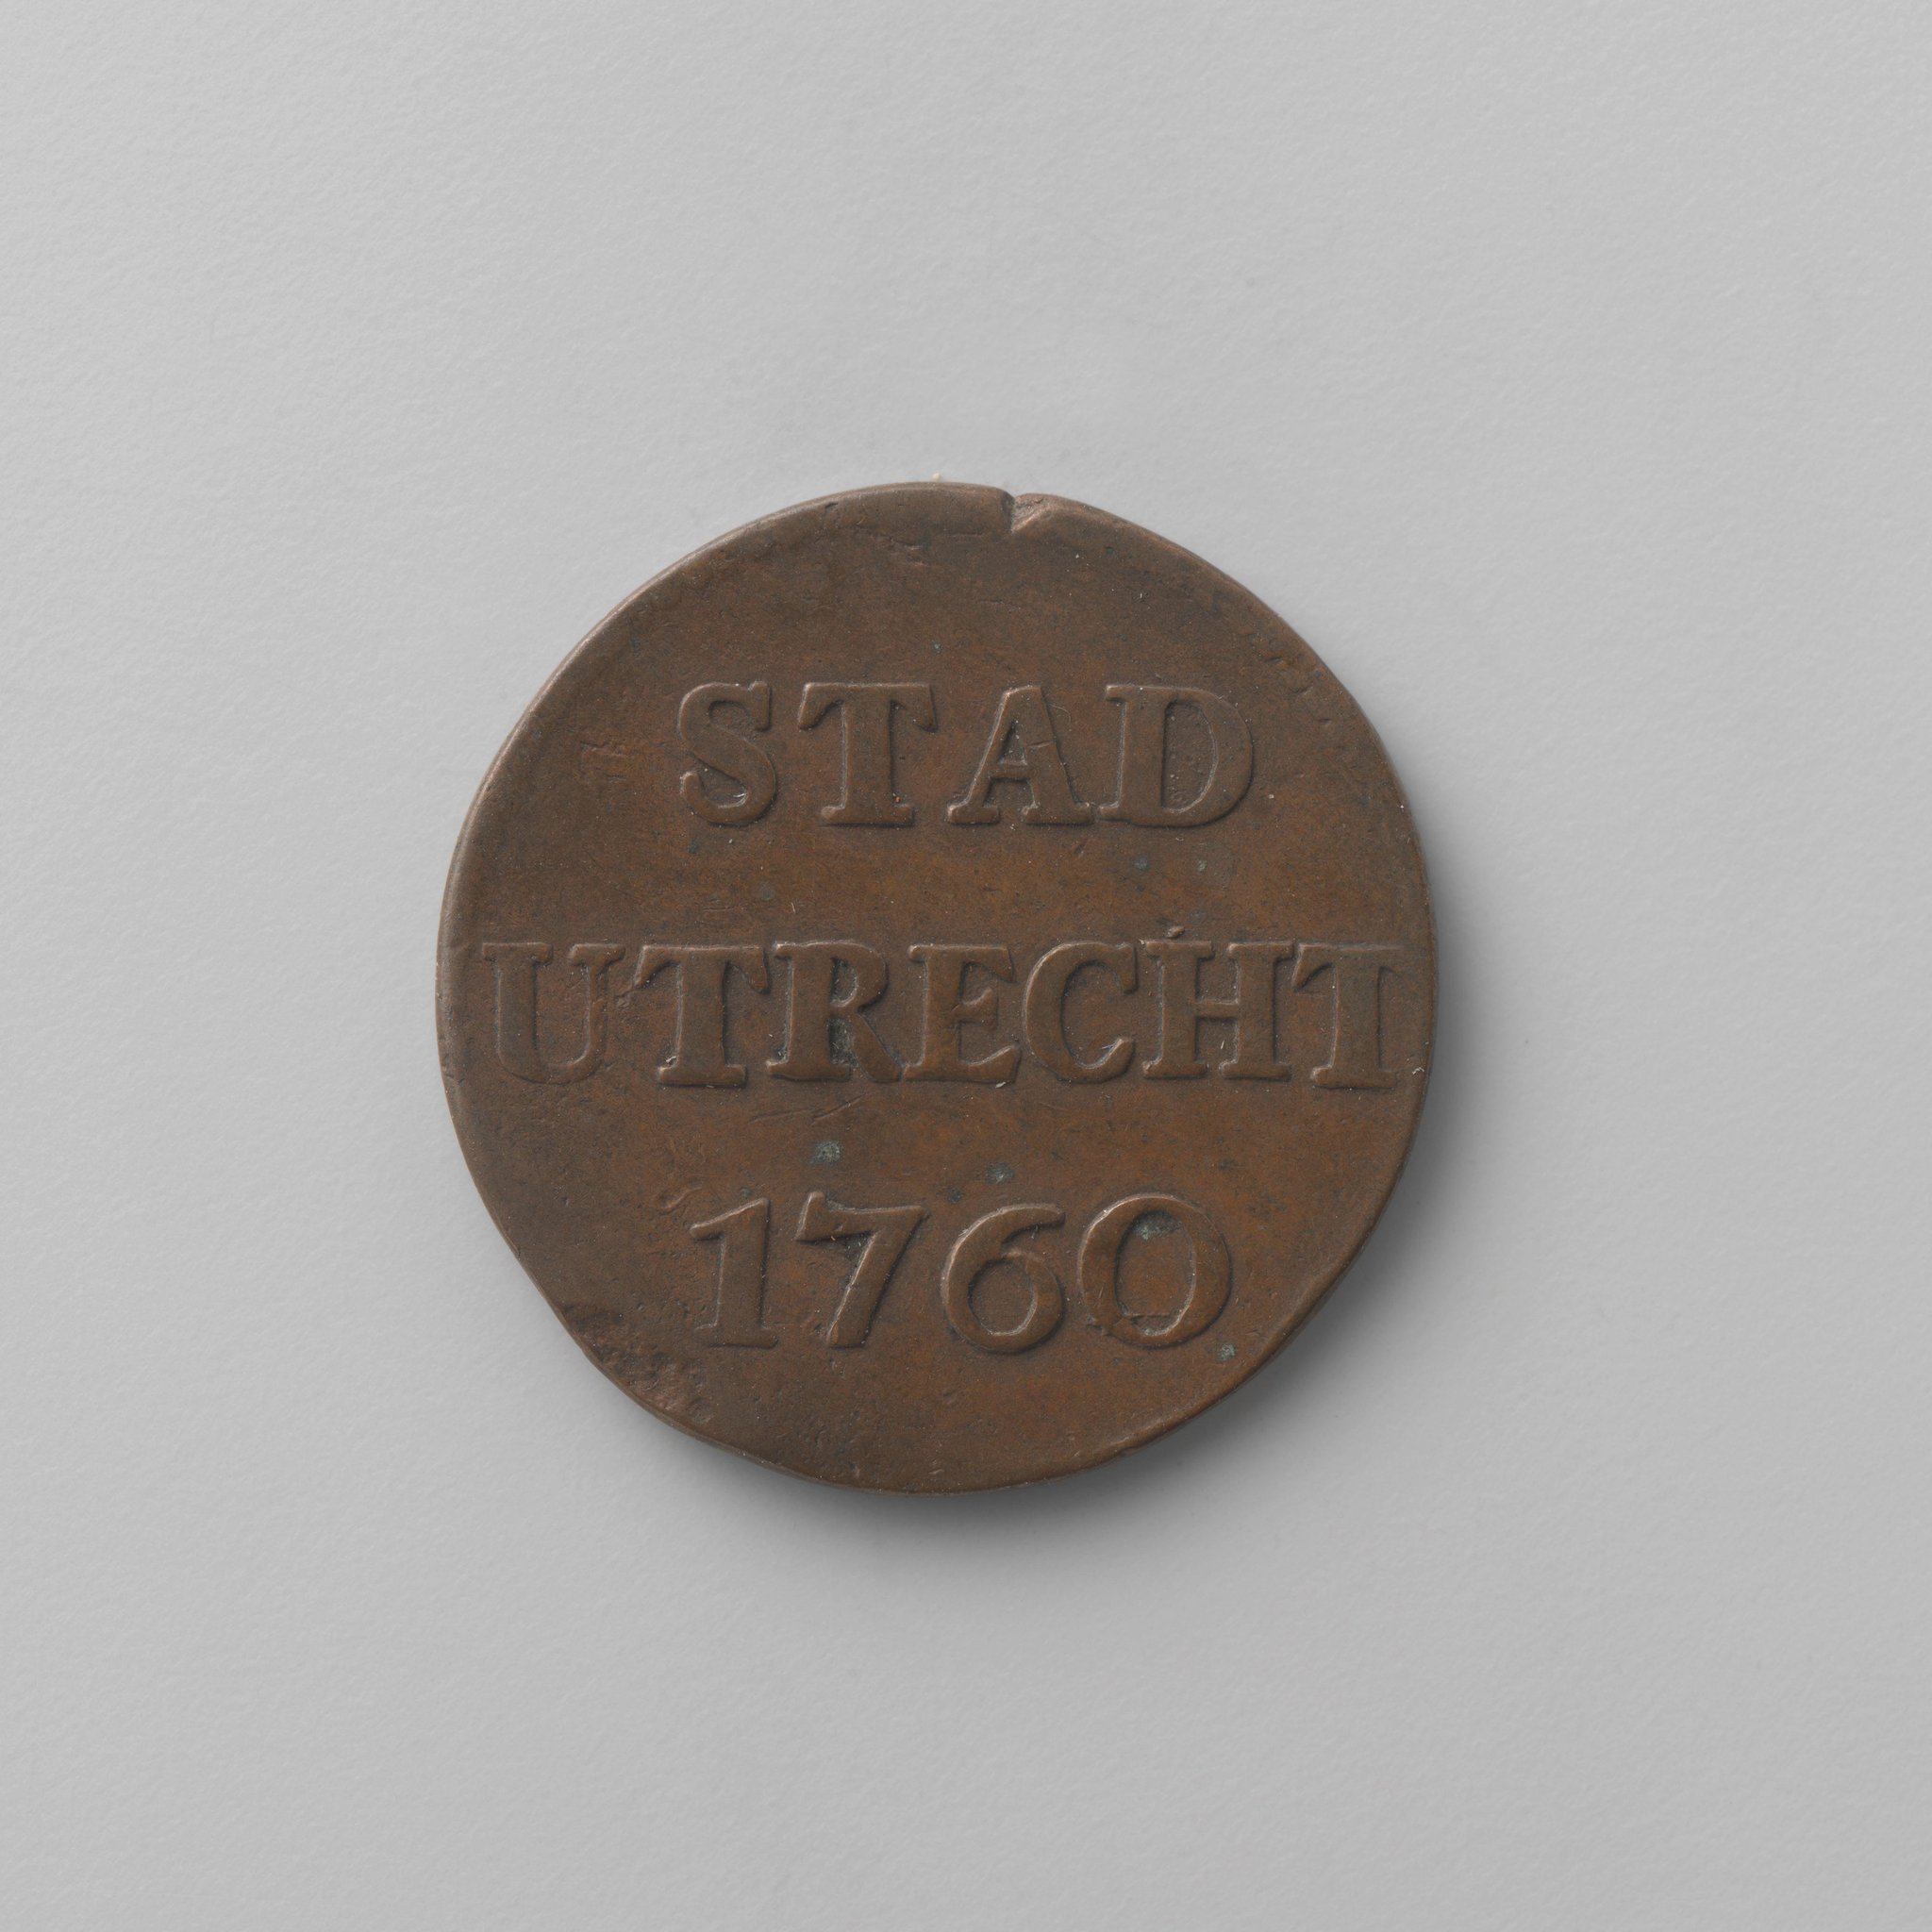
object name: coin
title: Stad Utrecht, duit, 1760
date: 1760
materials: copper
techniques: striking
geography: utrecht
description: Koperen munt. Voorzijde: gekroond stedelijk wapenschild, gehouden door twee leeuwen met in afsnede dikke lijn, waaronder een versierde accolade met een grote schelp. Keerzijde: opschrift in twee regels, waaronder jaartal. Jaartal met Arabische 1.